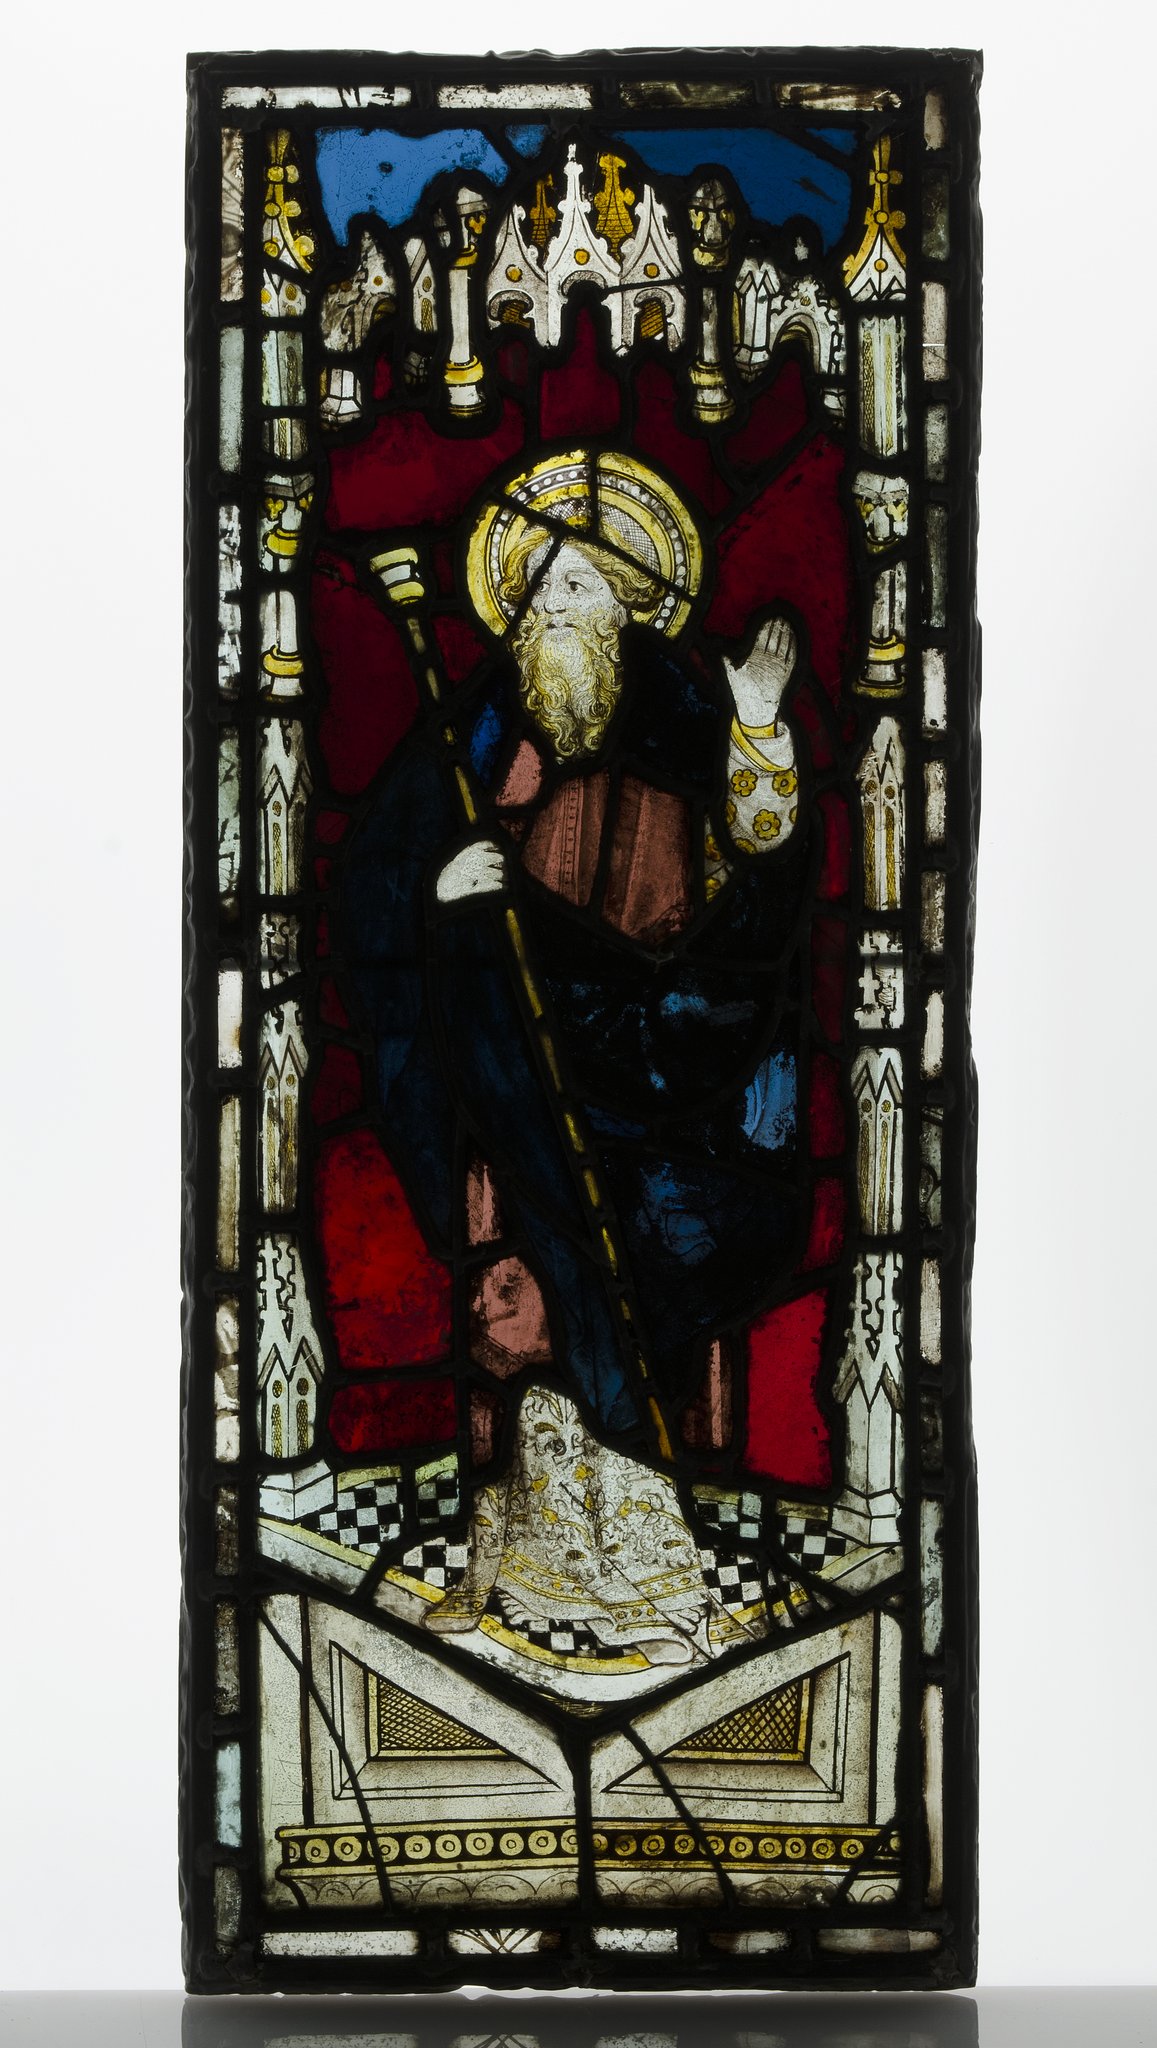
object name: panel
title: Panel with St. Anthony Abbot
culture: british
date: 1401-1600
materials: glass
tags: men,portraits